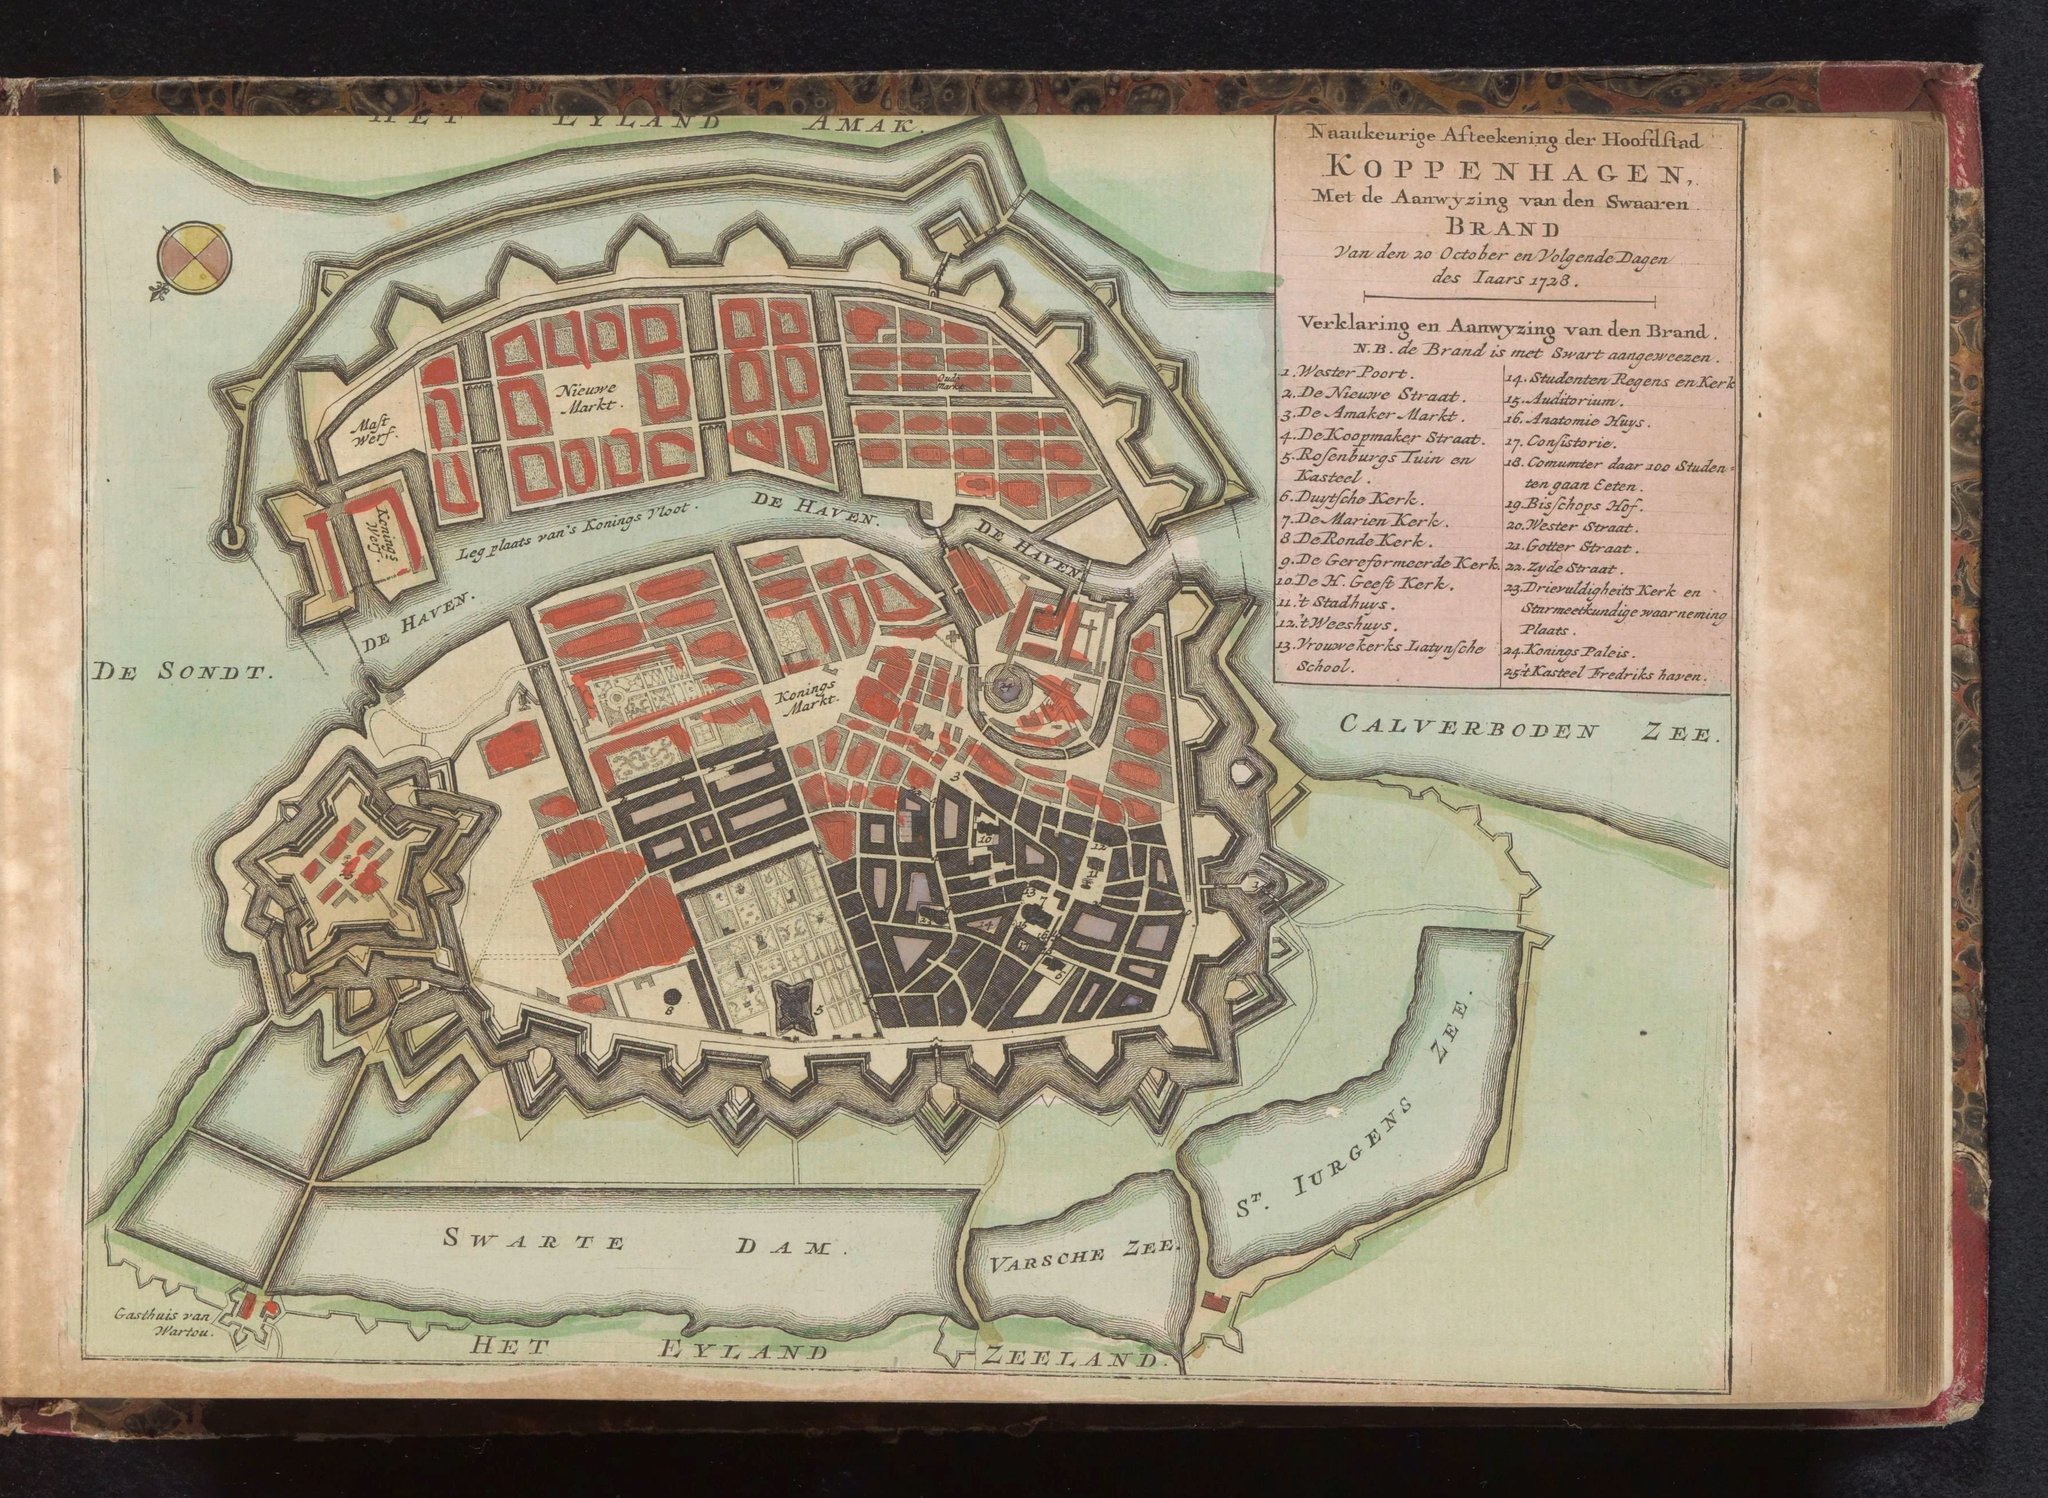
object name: map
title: Plattegrond van Kopenhagen, na de brand van 1728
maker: Anonymous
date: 1735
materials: paper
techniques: engraving, etching, hand coloring, lacquer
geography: northern netherlands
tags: maps of cities, copenhagen (city)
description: Plattegrond van de Deense hoofdstad Kopenhagen, waarop aangegeven de delen van de stad die getroffen zijn door de brand op 20 oktober 1728. Onderdeel van een atlas met 223 kaarten van landen en steden en oorlogstaferelen in Europa in de periode ca. 1690-1735.